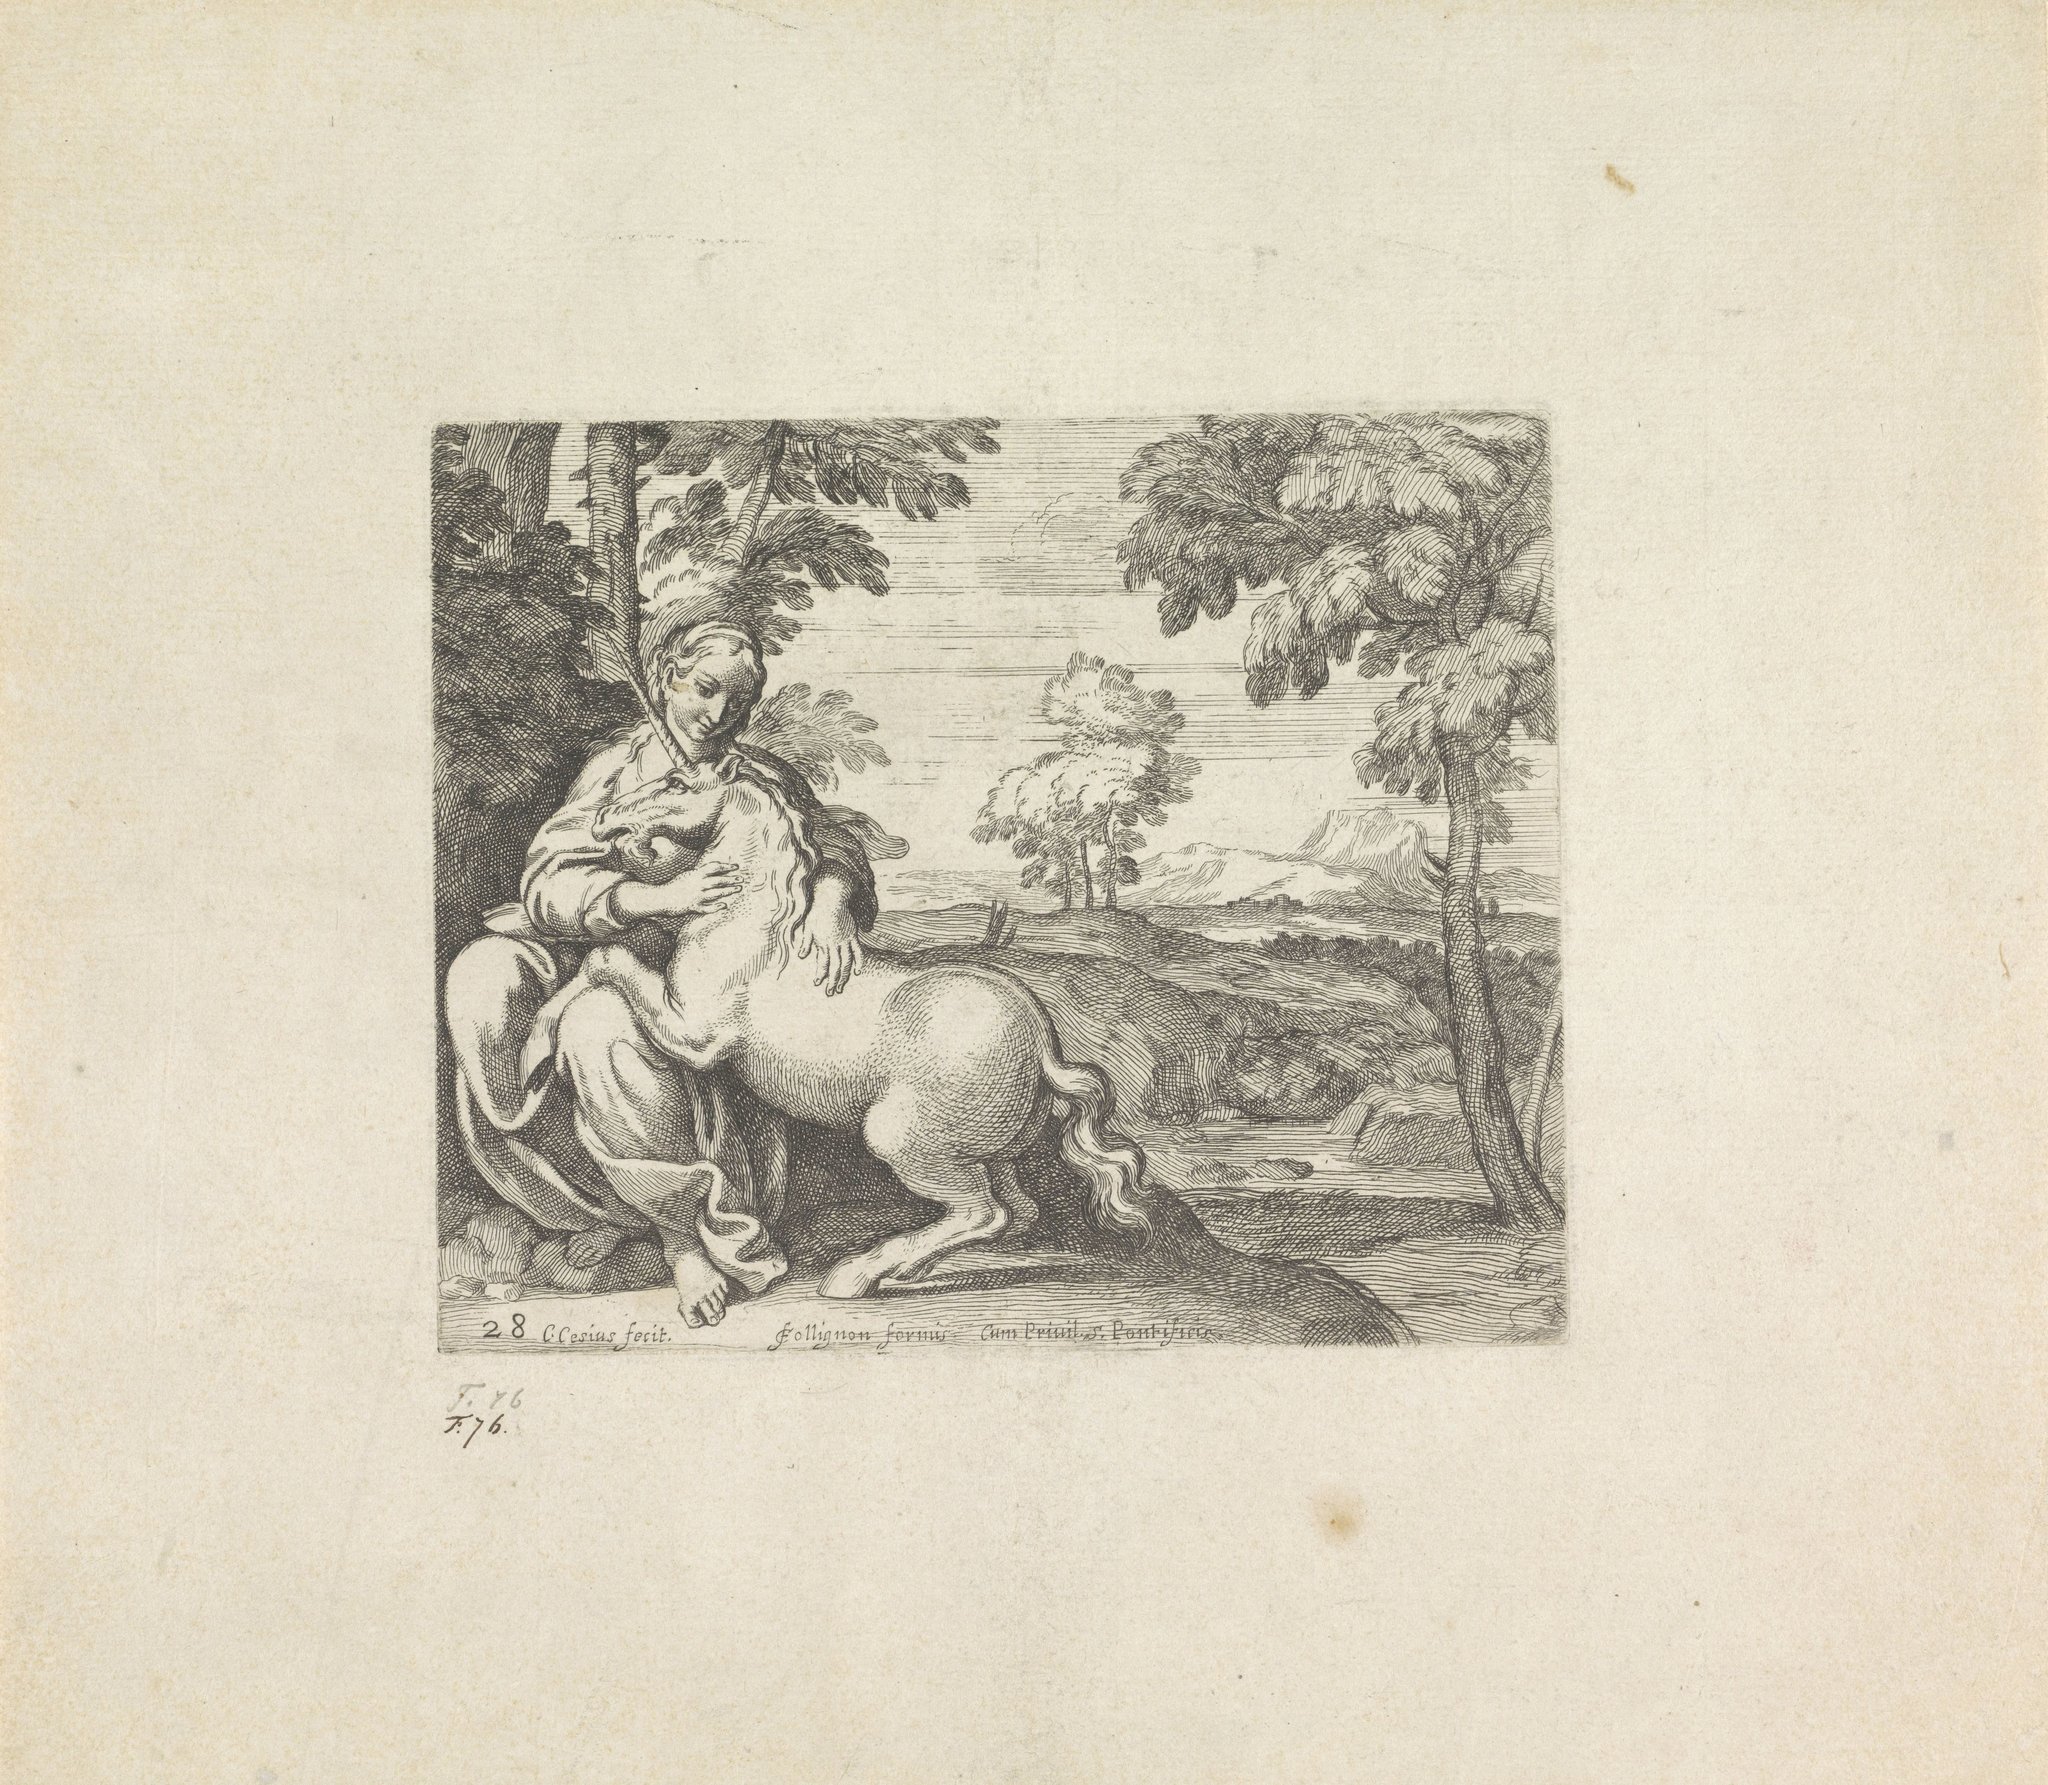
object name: print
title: Galeria nel Palazzo Farnese in Roma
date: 1656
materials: paper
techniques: etching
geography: rome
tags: unicorn, philyra beloved by saturn, occasionally in the shape of a horse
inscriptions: collector's mark: Lugt 2228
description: Prent uit een reeks prenten met nummers van 1 tot en met 29 (sommige prenten hebben hetzelfde nummer), plus titelprent en opdracht, naar schilderingen in Palazzo Farnese te Rome.